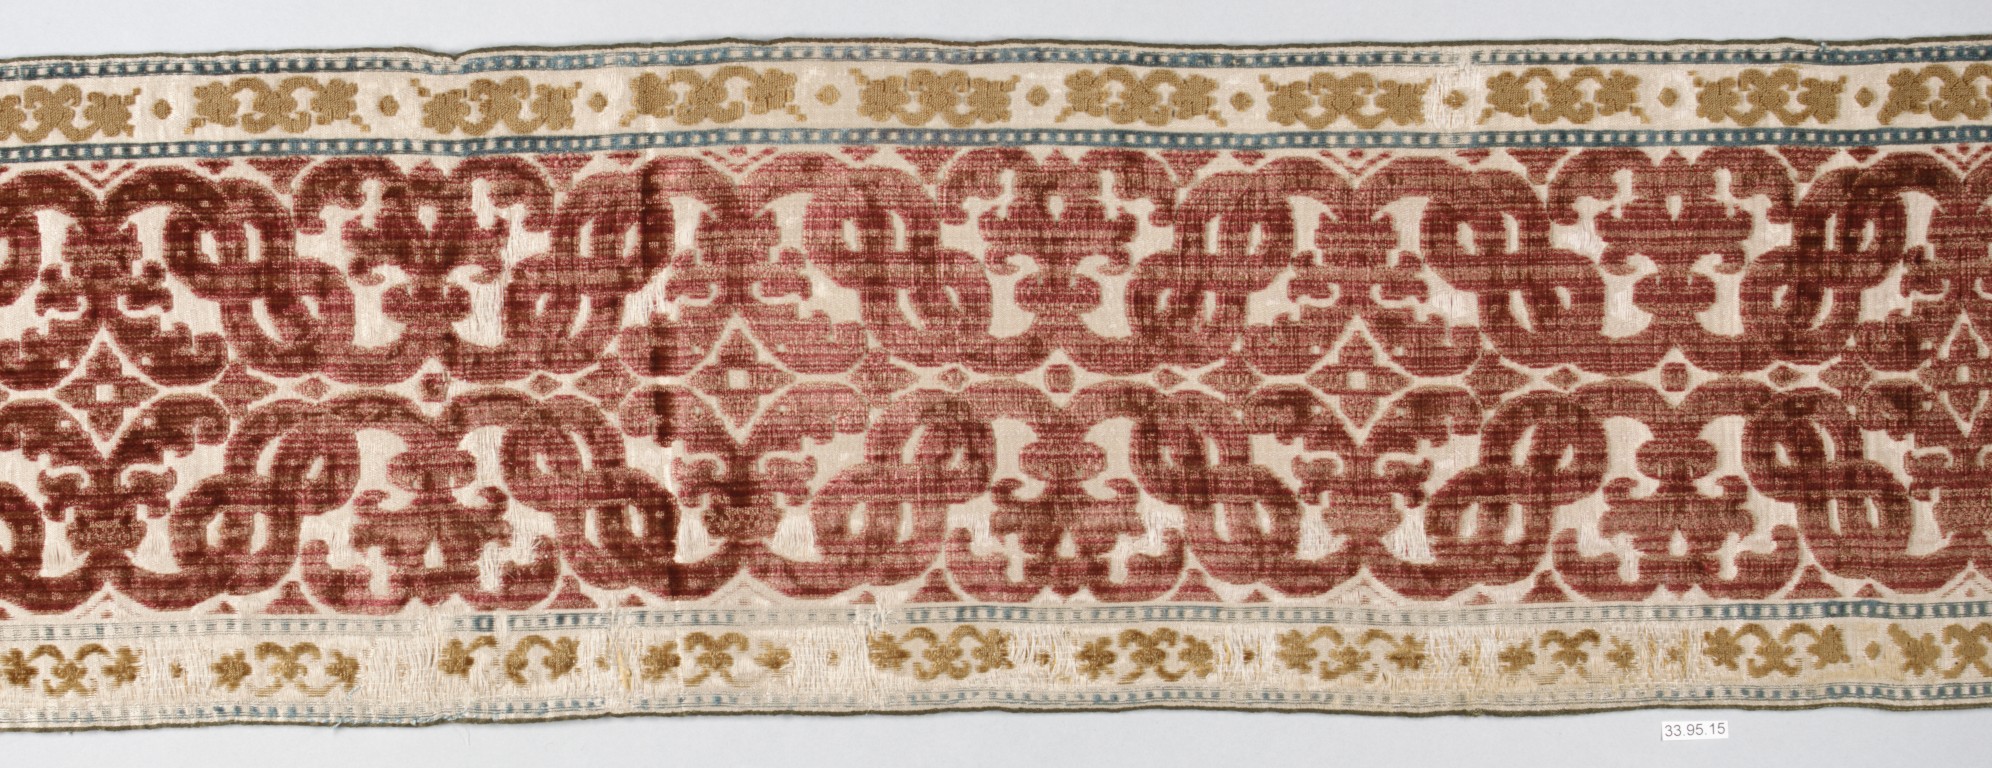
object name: border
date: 1551-1600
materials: silk